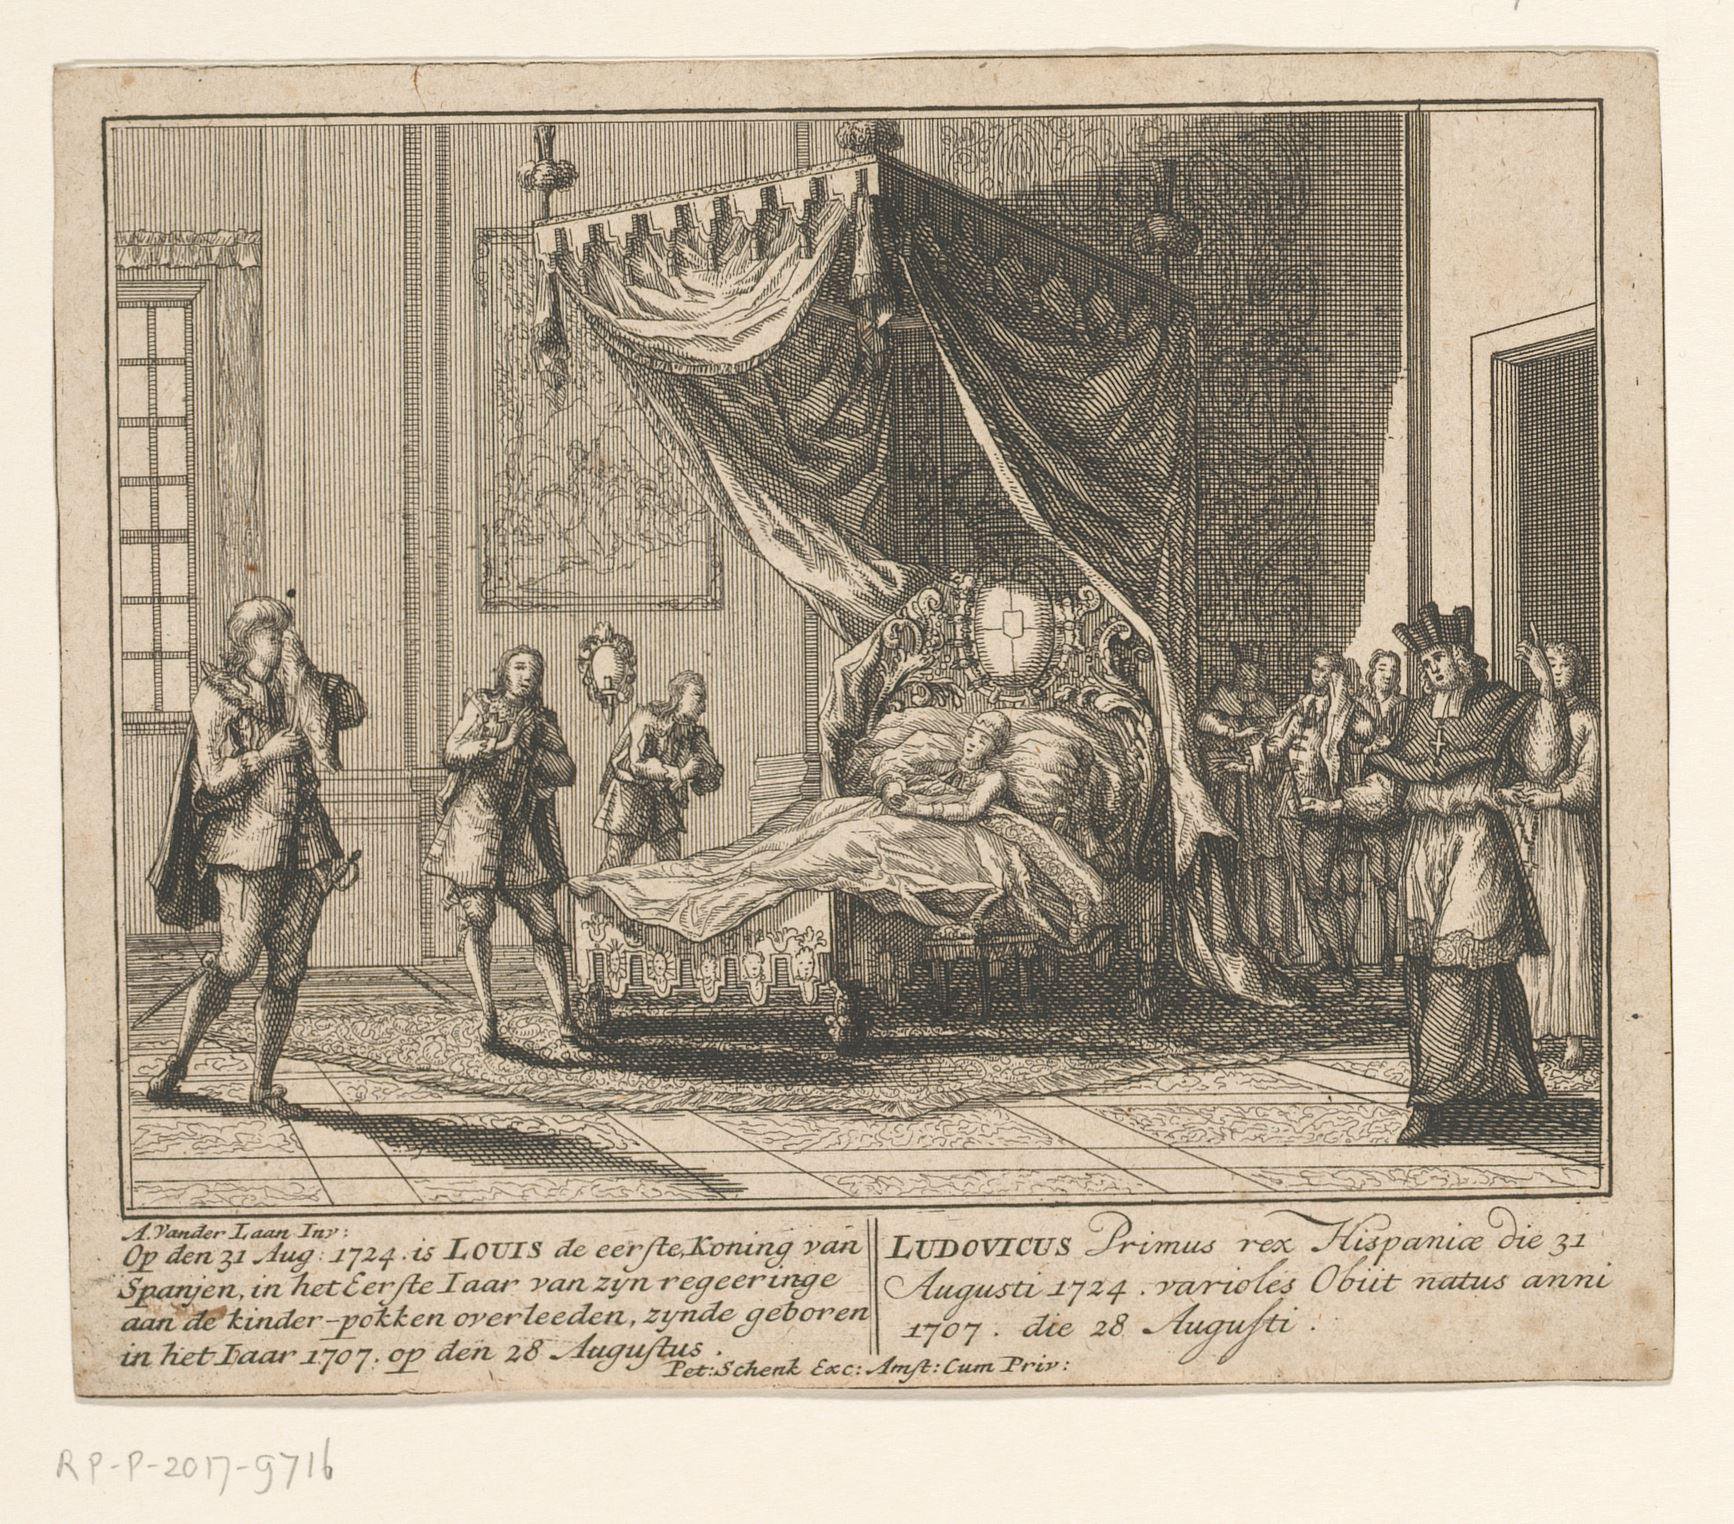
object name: print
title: Sterfbed van koning Lodewijk I van Spanje, 1724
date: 1724-1727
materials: paper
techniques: etching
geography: amsterdam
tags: deathbed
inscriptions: collector's mark: Lugt 2228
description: Onderdeel van een blad met negen voorstellingen van gebeurtenissen uit het jaar 1724. Opschriften in de voorstelling in het Nederlands en Latijn. Zie : plaat 30 in het prentwerk met de gebundelde reeks van 33 platen met voorstellingen van gebeurtenissen uit de jaren 1700-1727 van de Spaanse Successieoorlog en de jaren daarna, kaarten en plattegronden.